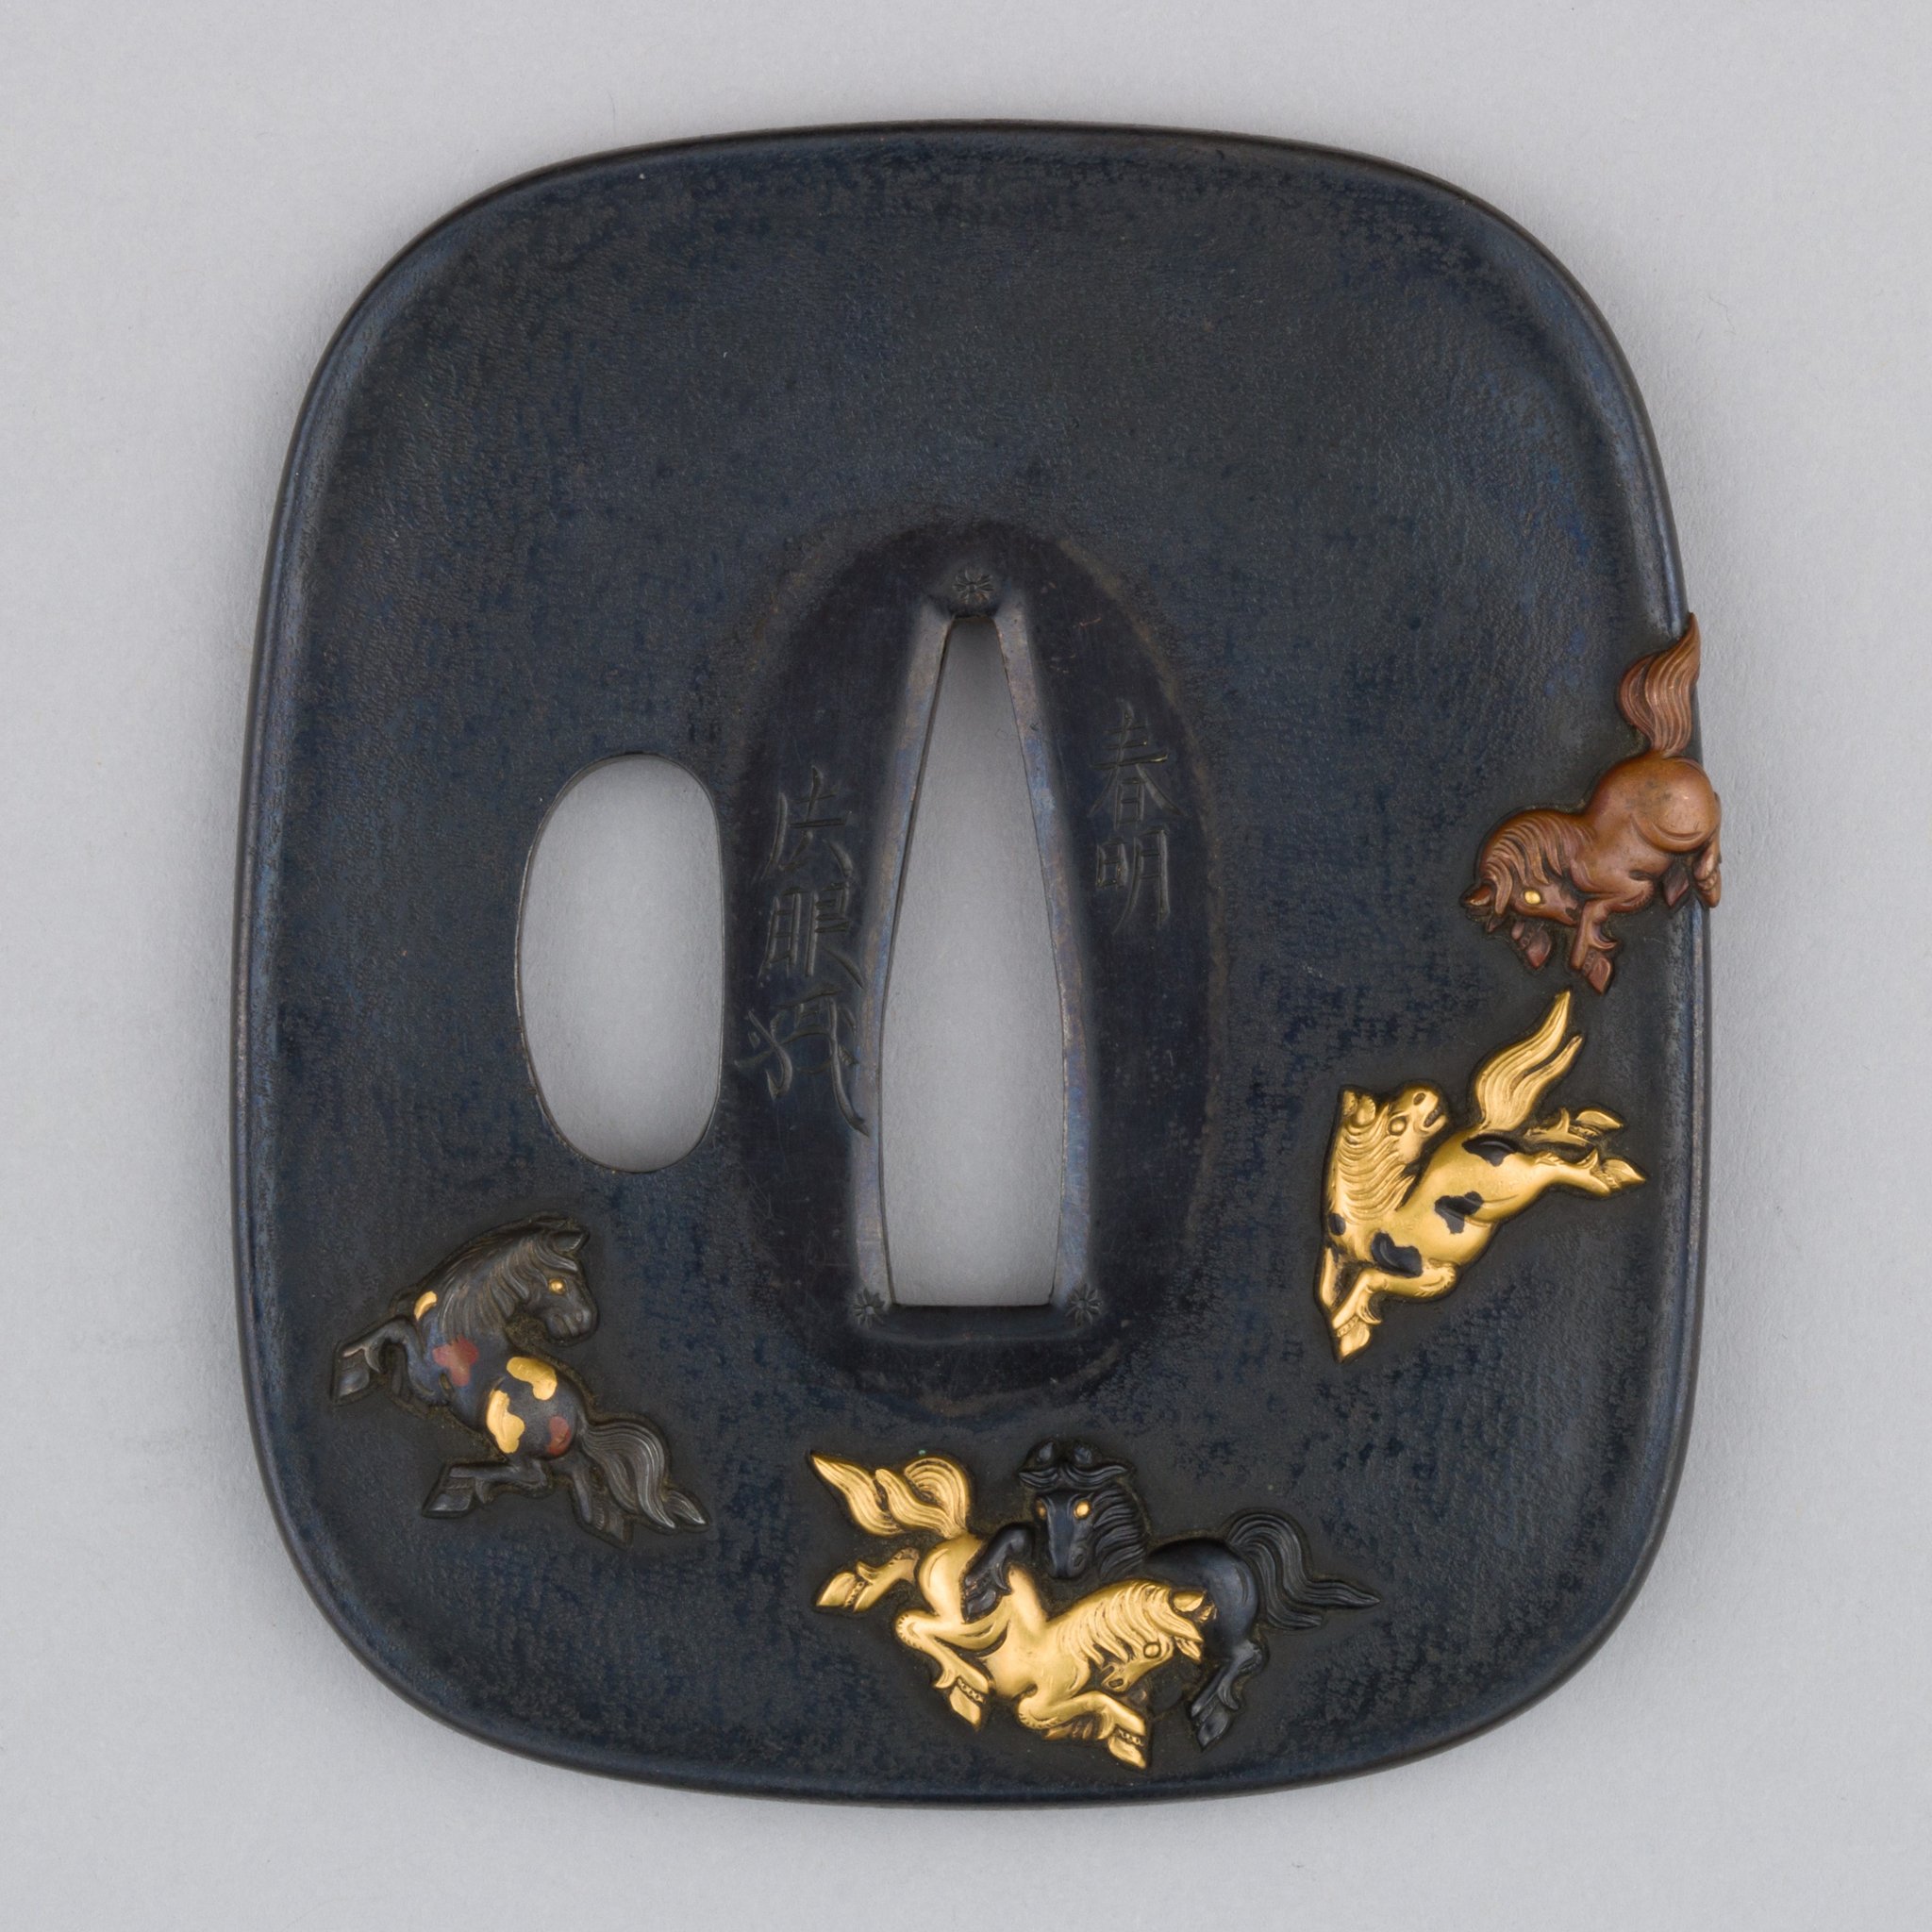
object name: sword guard tsuba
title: Sword Guard (Tsuba)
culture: japanese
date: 1615-1868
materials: copper, gold alloy, silver alloy, gold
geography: japan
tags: horses